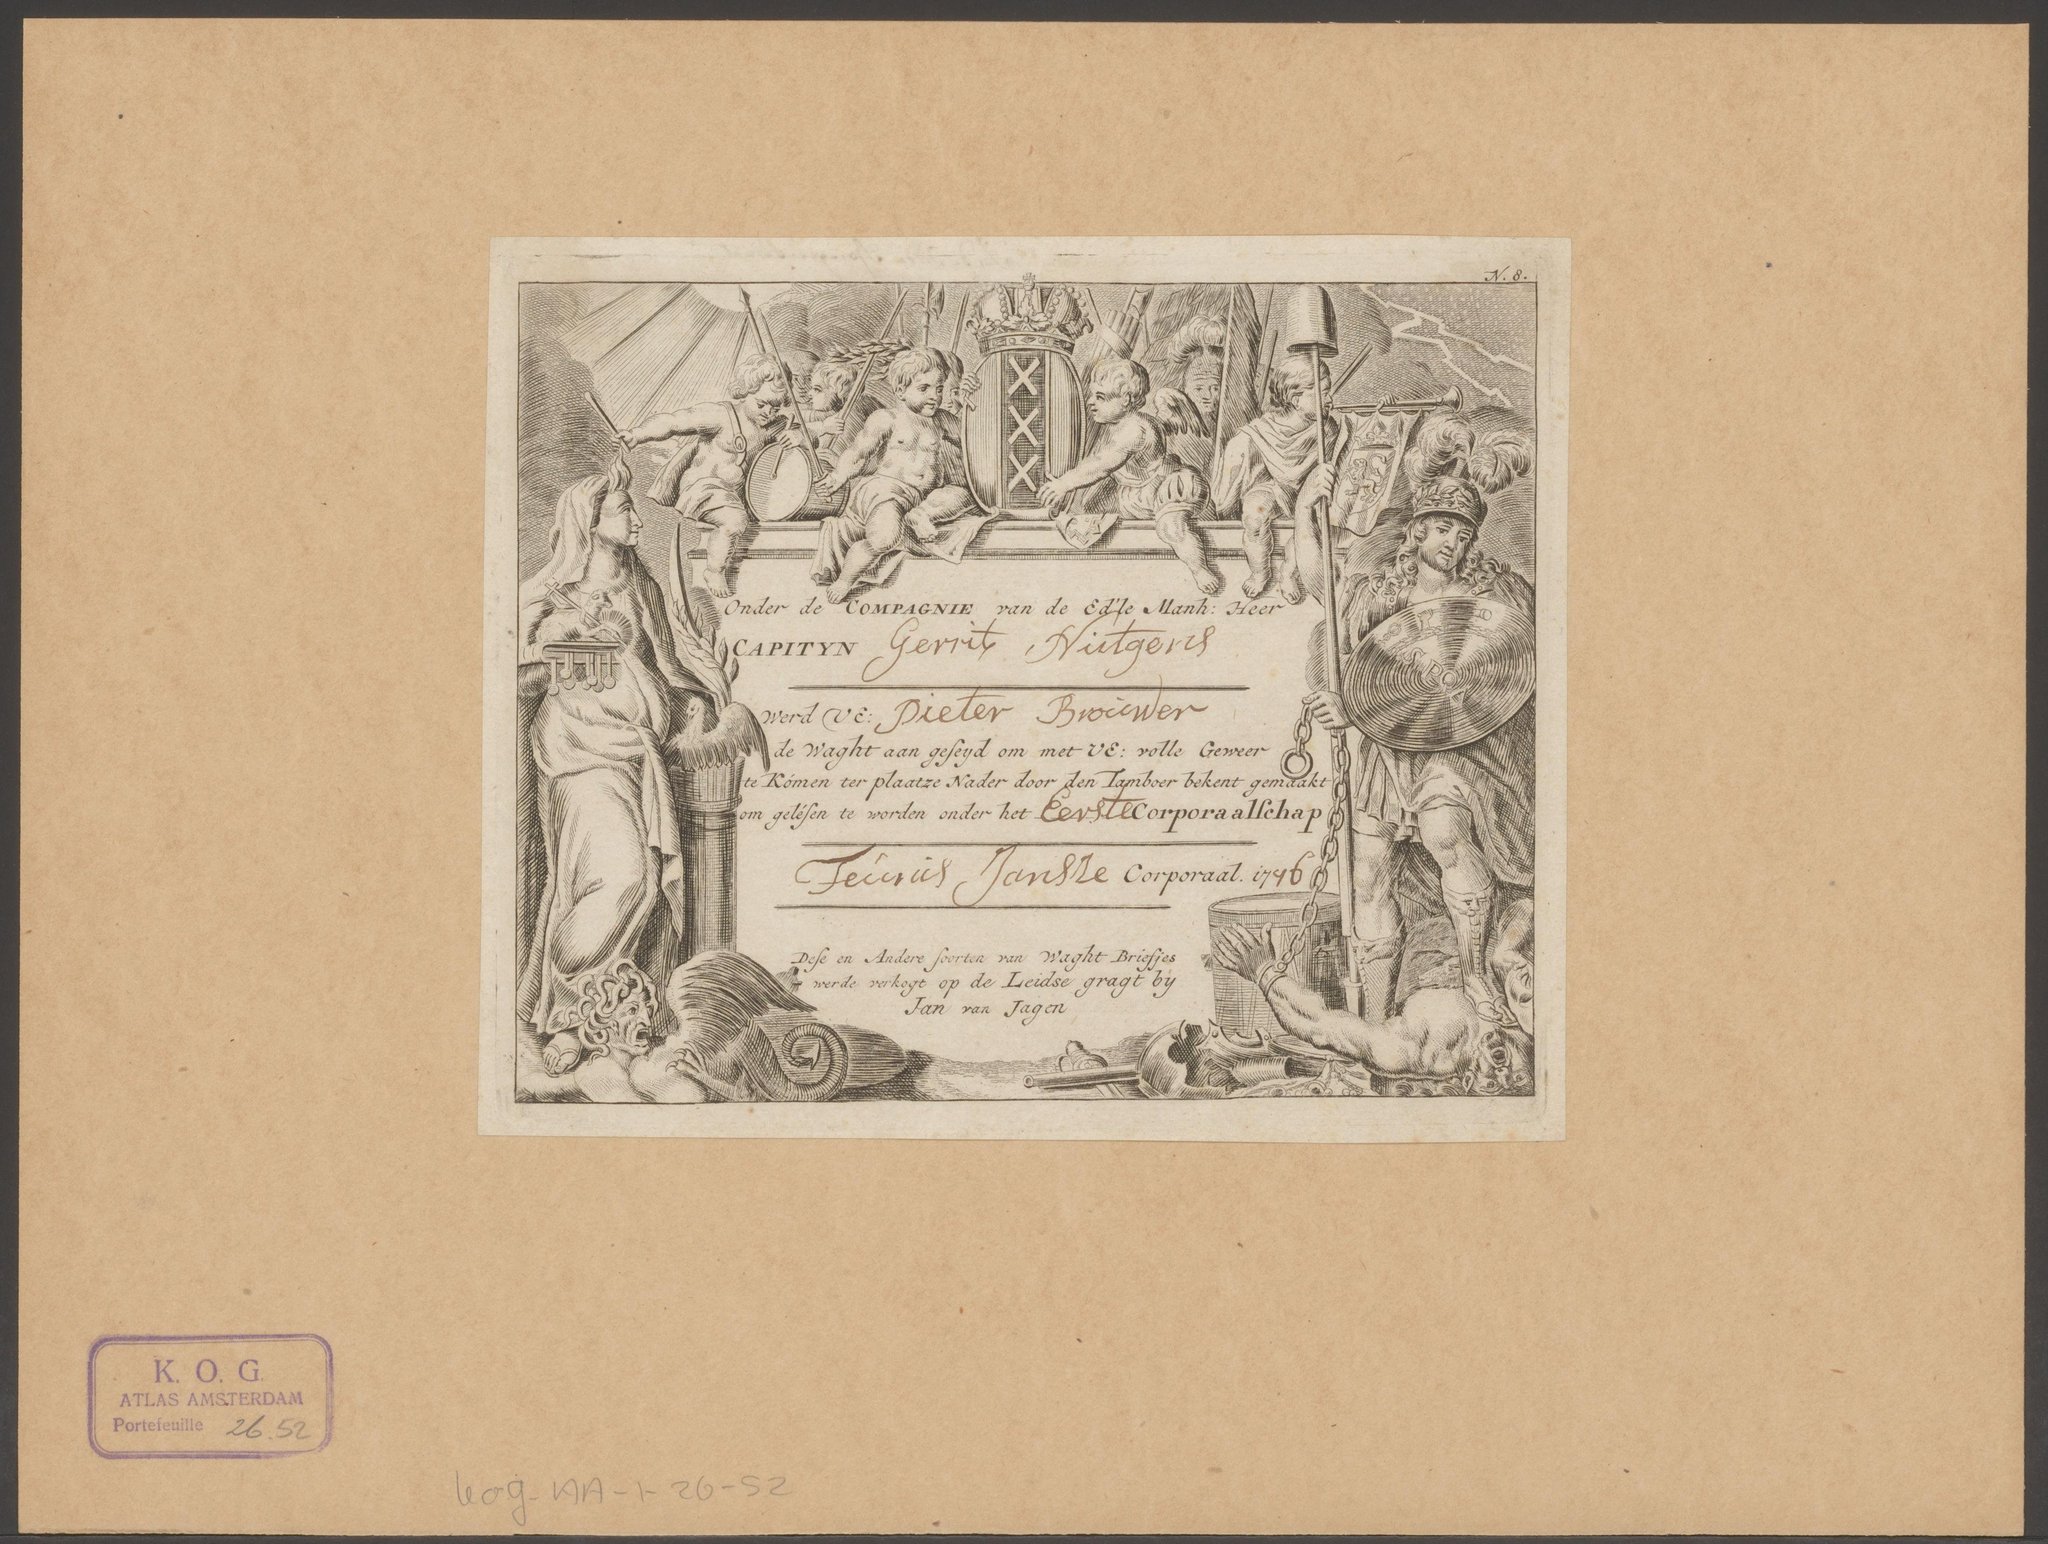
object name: schuttersbiljet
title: Schuttersbrief van kapitein Gerrit Nutgens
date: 1746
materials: paper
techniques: engraving, etching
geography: northern netherlands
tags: coat of arms (as symbol of the state, etc.) (+ city; municipal), the archangel michael (often in armour with sword or lance), freedom, liberty; 'libertà' (ripa), cupids: 'amores', 'amoretti', 'putti', amsterdam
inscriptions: collector's mark: Lugt 1641b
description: Schuttersbrief met oproep van kapitein Gerrit Nutgens, gericht aan Pieter Brouwer, om zich bij het eerste korporaalschap van corporaal Jansze van de Amsterdamse schutterij te melden. Voorgedrukte brief met open delen die met pen zijn ingevuld. Rechtsboven genummerd: N. 8. Onderwerpsrubriek binnen de Atlas Amsterdam: Schutters-oproepingsbriefjes.